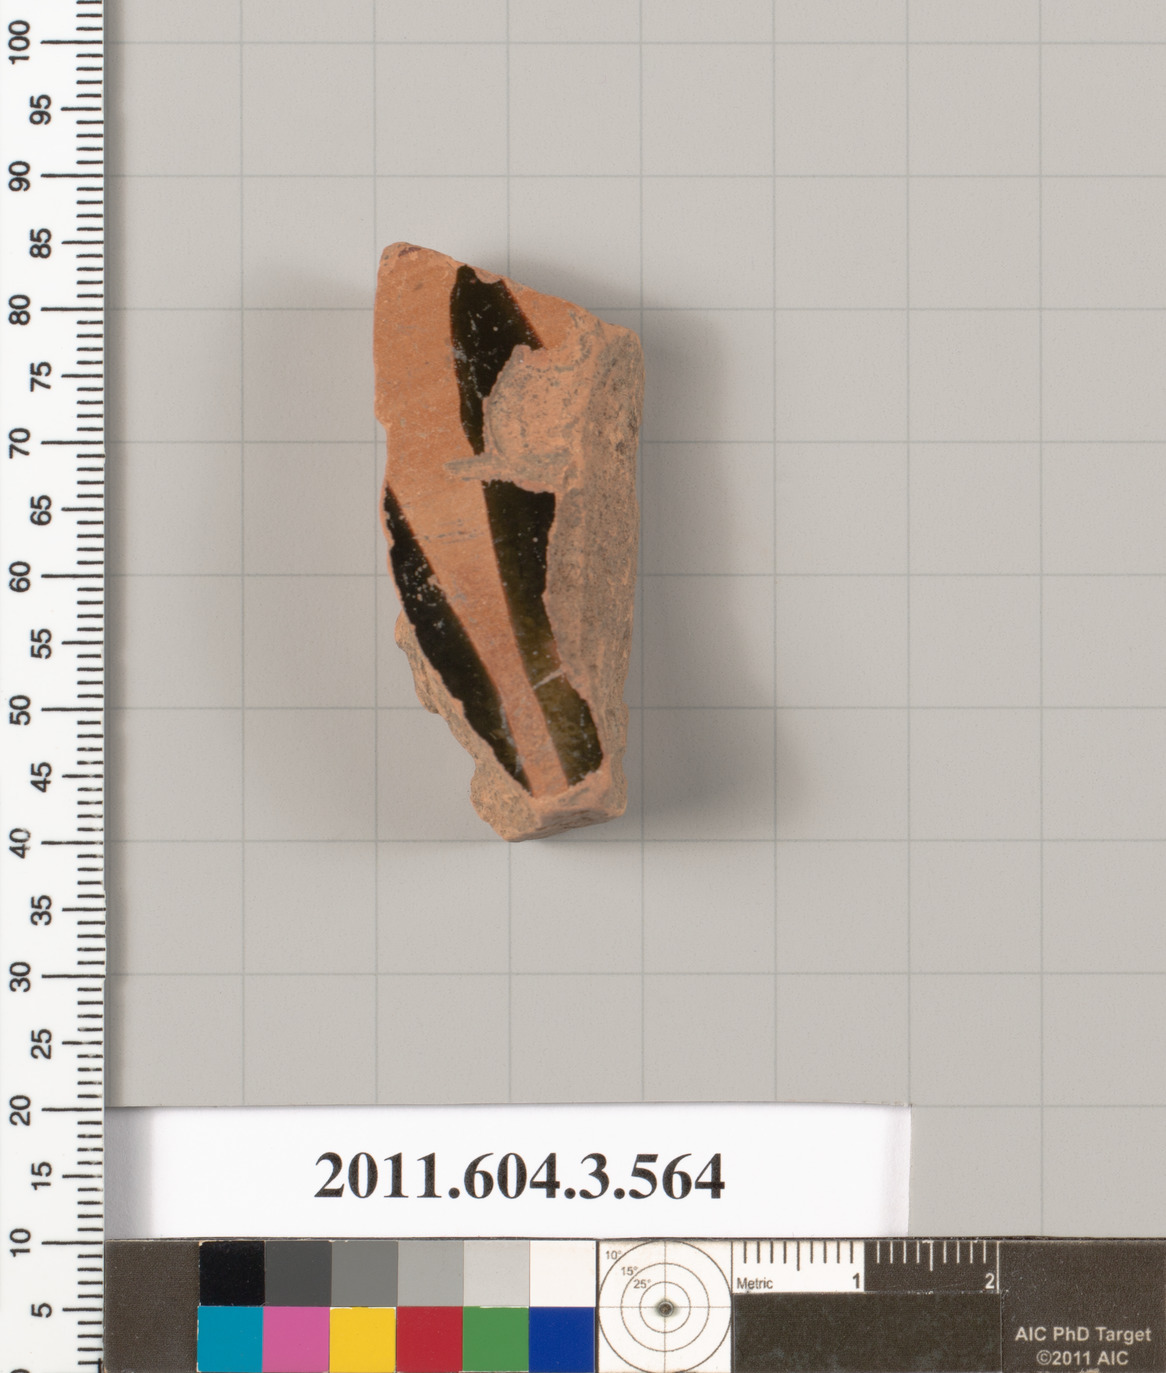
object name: column krater fragment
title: Terracotta fragment of a column-krater (bowl for mixing wine and water)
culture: greek, attic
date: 600-401 BCE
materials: terracotta